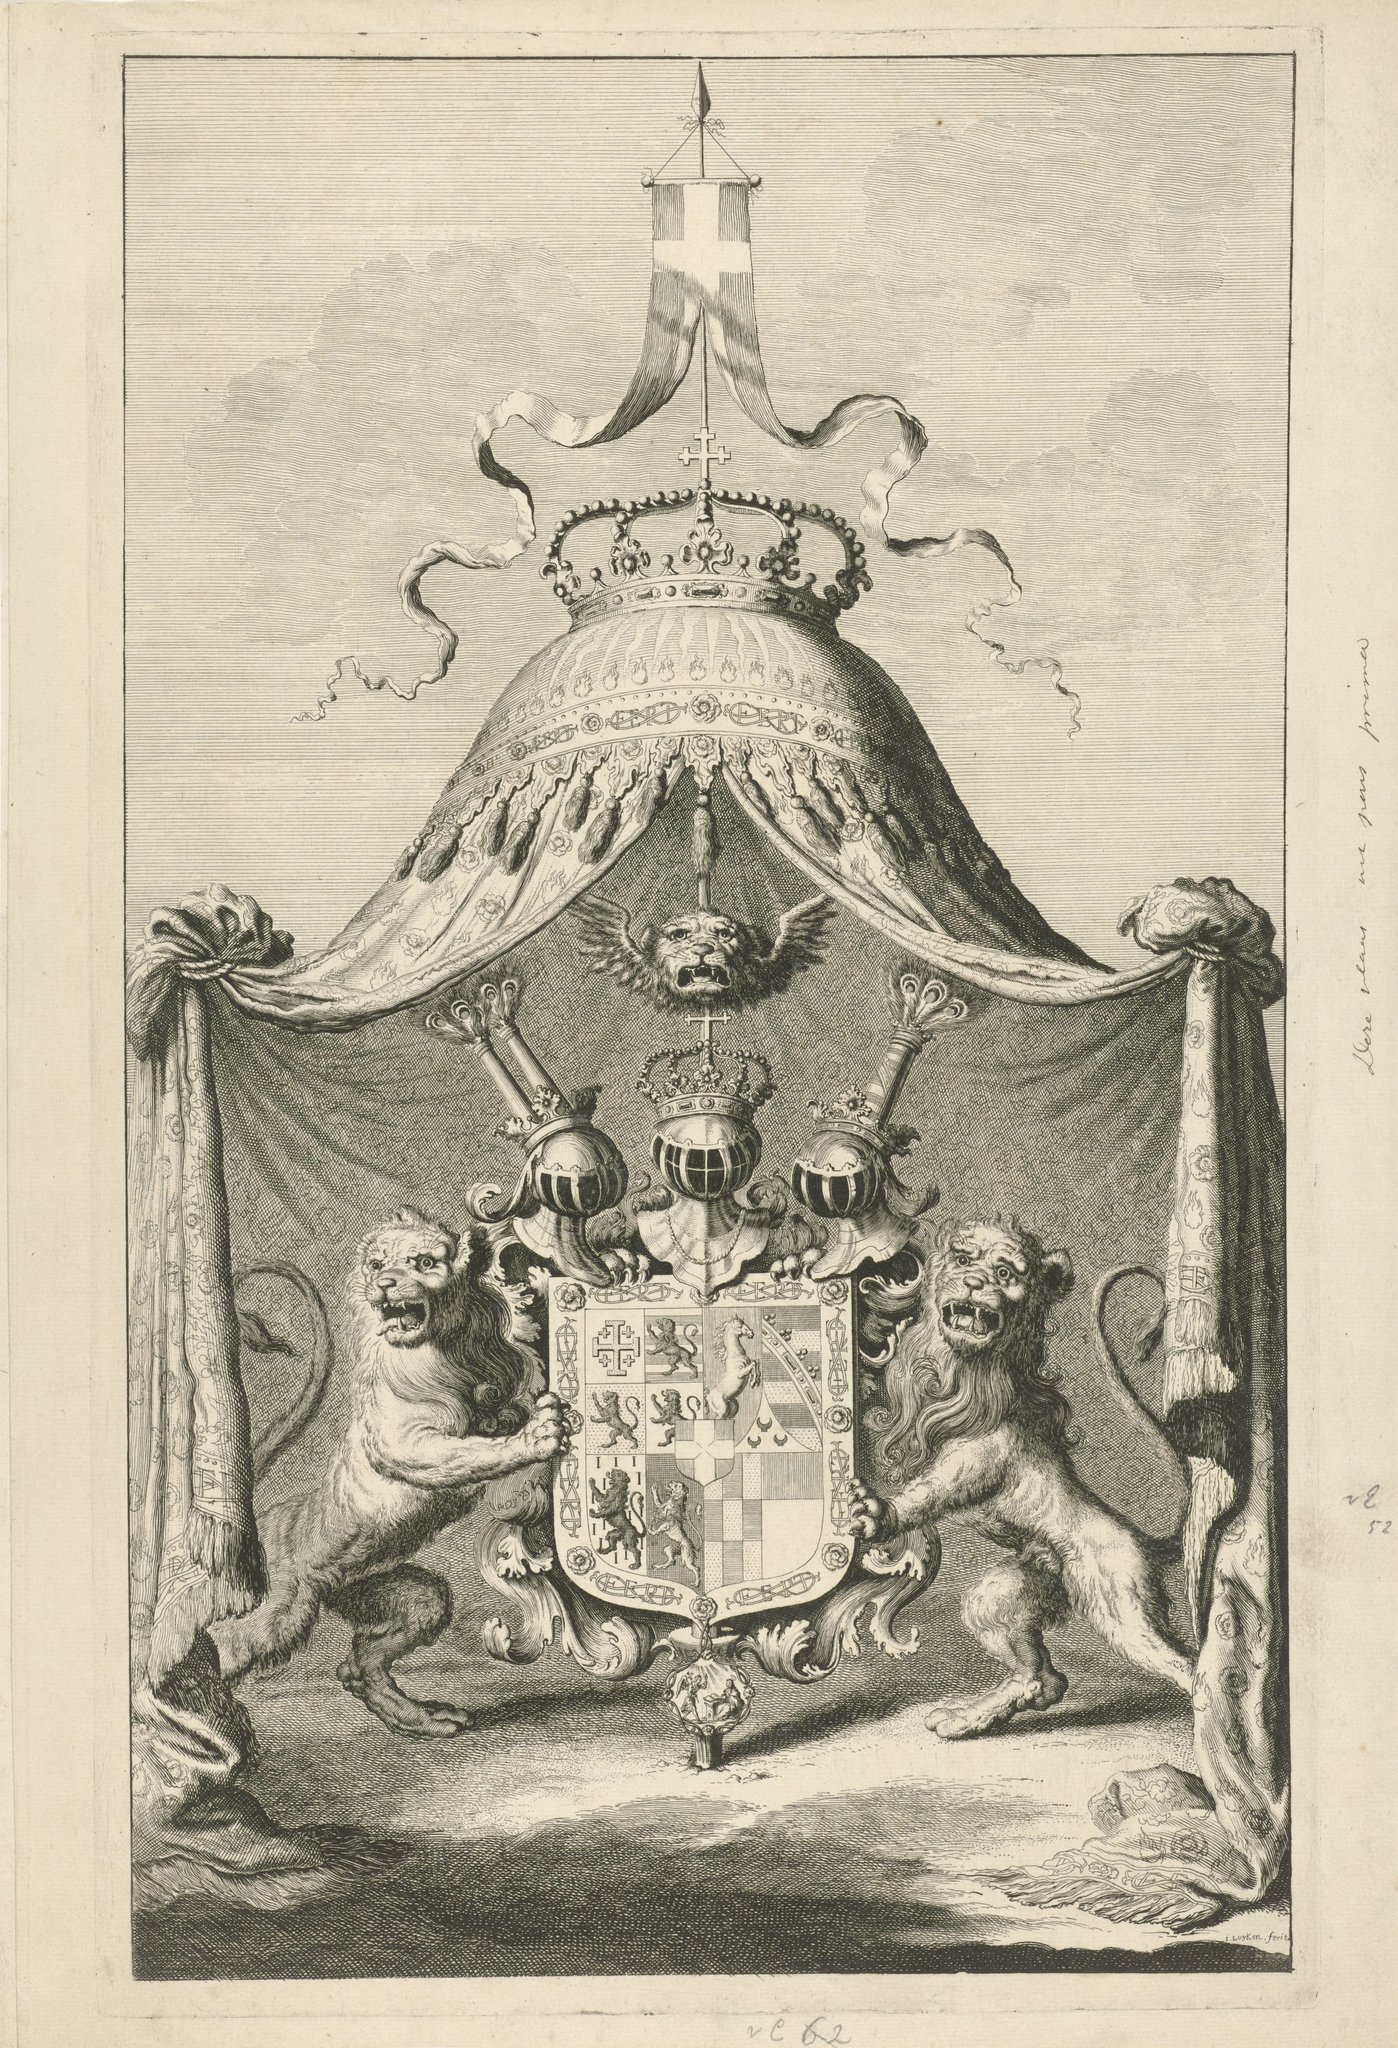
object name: book illustration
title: Wapenschild van Savoye geflankeerd door twee leeuwen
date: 1682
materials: paper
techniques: etching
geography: amsterdam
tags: coat of arms (as symbol of the state, etc.) (+ city; municipal), beasts of prey, predatory animals: lion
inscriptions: collector's mark: Lugt 2228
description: Illustratie opgenomen in: Blaeu, Joan. Theatrum statuum regiae celsitudinis Sabaudiae ducis, 2 delen. Amsterdam: Johannes Blaeu (erven), 1682.